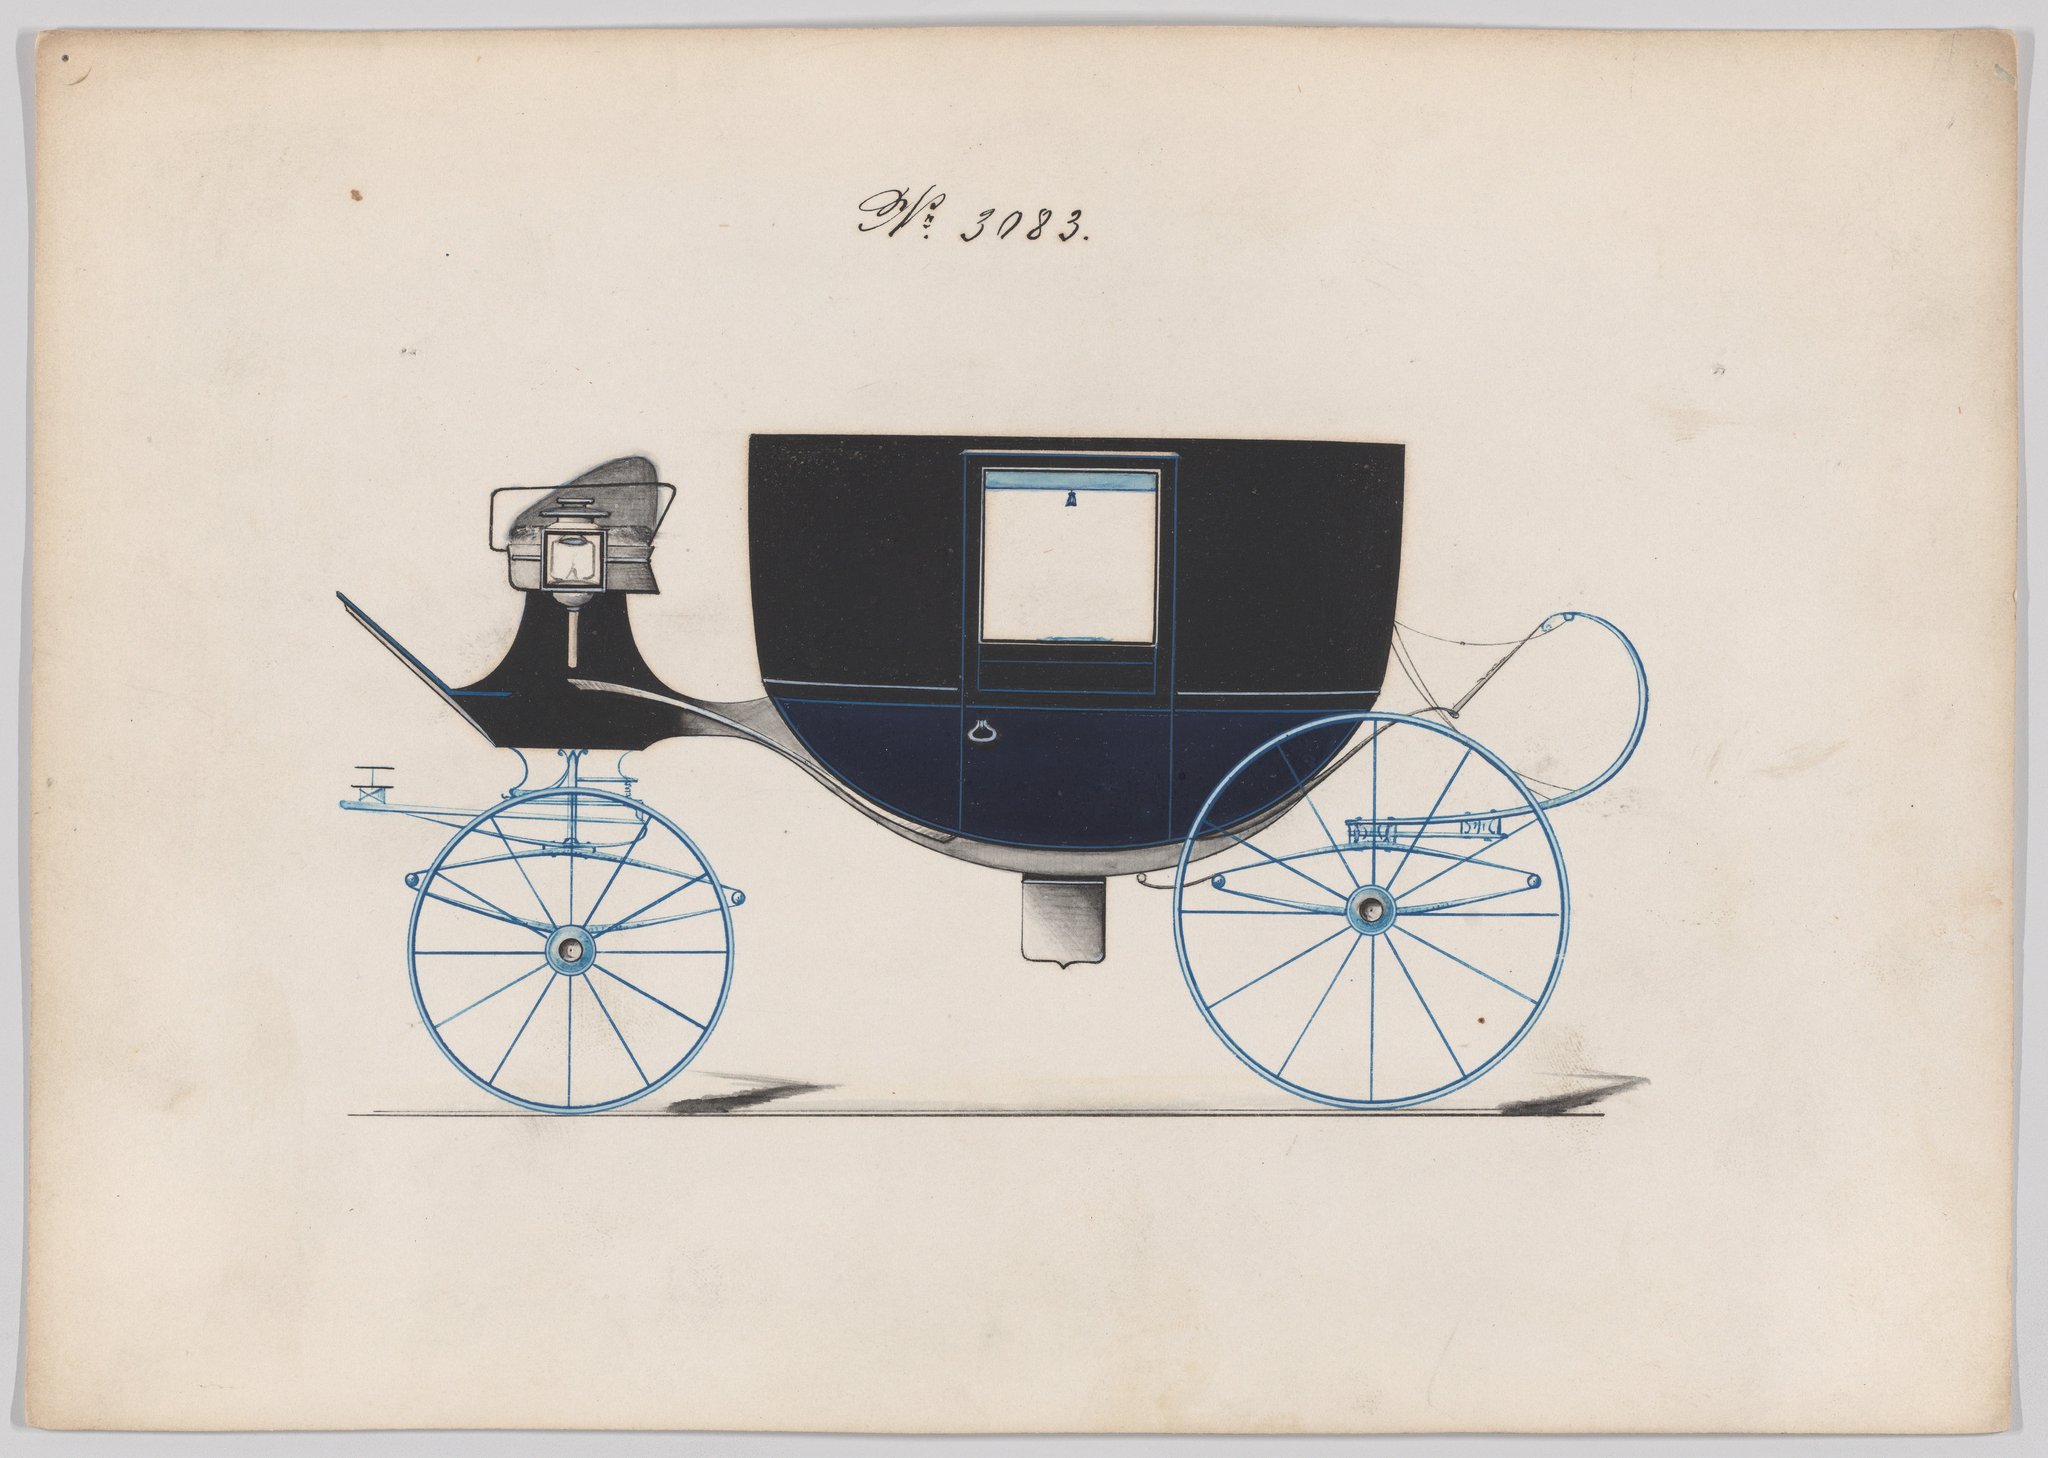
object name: drawing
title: Coach #3083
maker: brewster & co.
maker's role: manufacturer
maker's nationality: american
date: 1874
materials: gouache, ink, watercolor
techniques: pen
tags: carriages